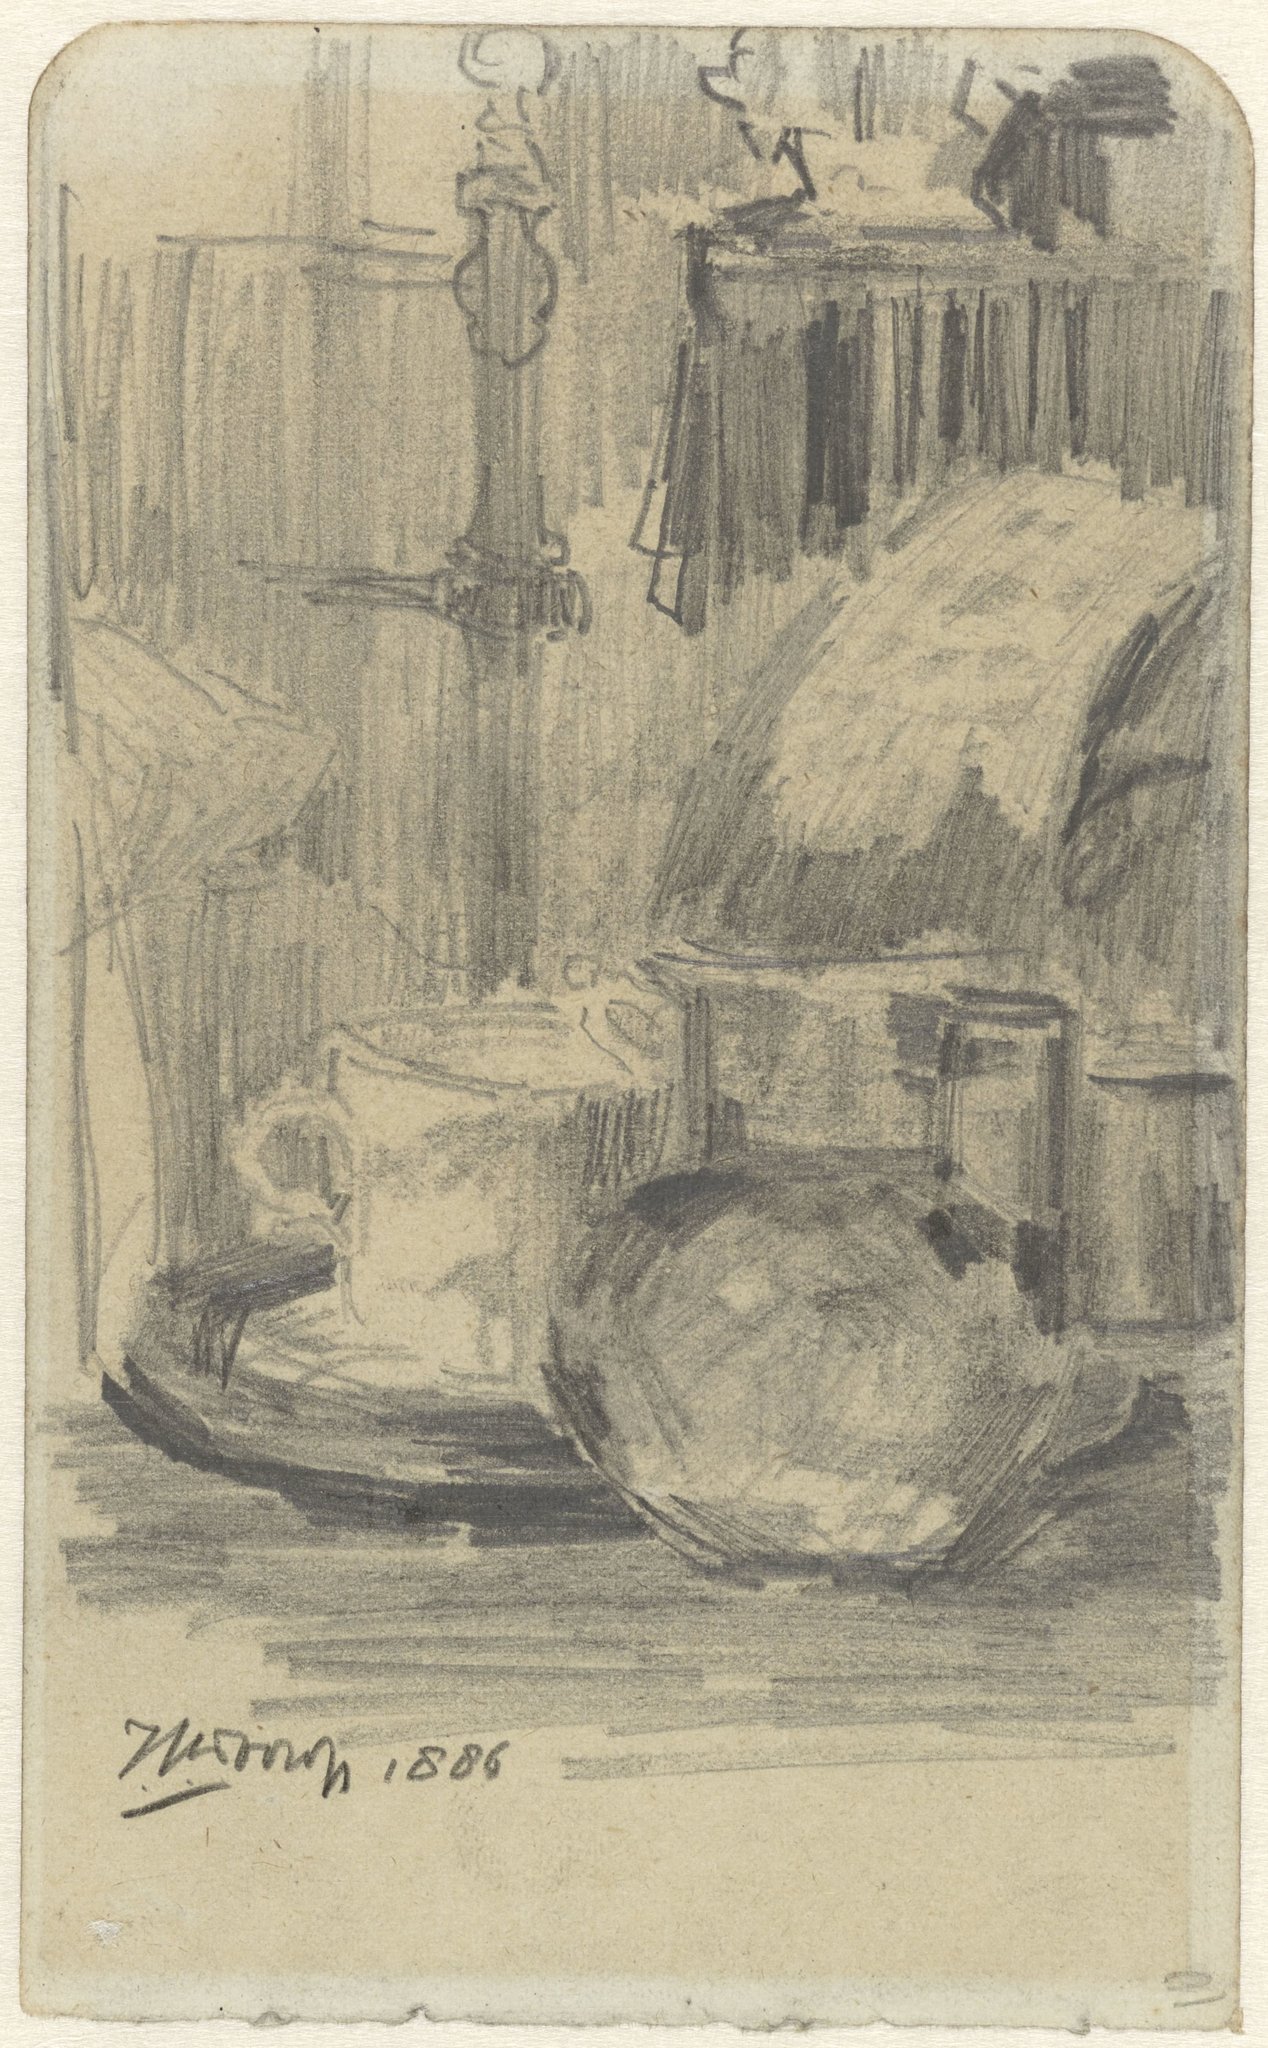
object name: drawing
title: Stilleven met kan en kopje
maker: jan toorop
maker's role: draughtsman, painter, print maker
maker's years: 1858-1928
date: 1886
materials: paper, pencil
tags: laid table as still life